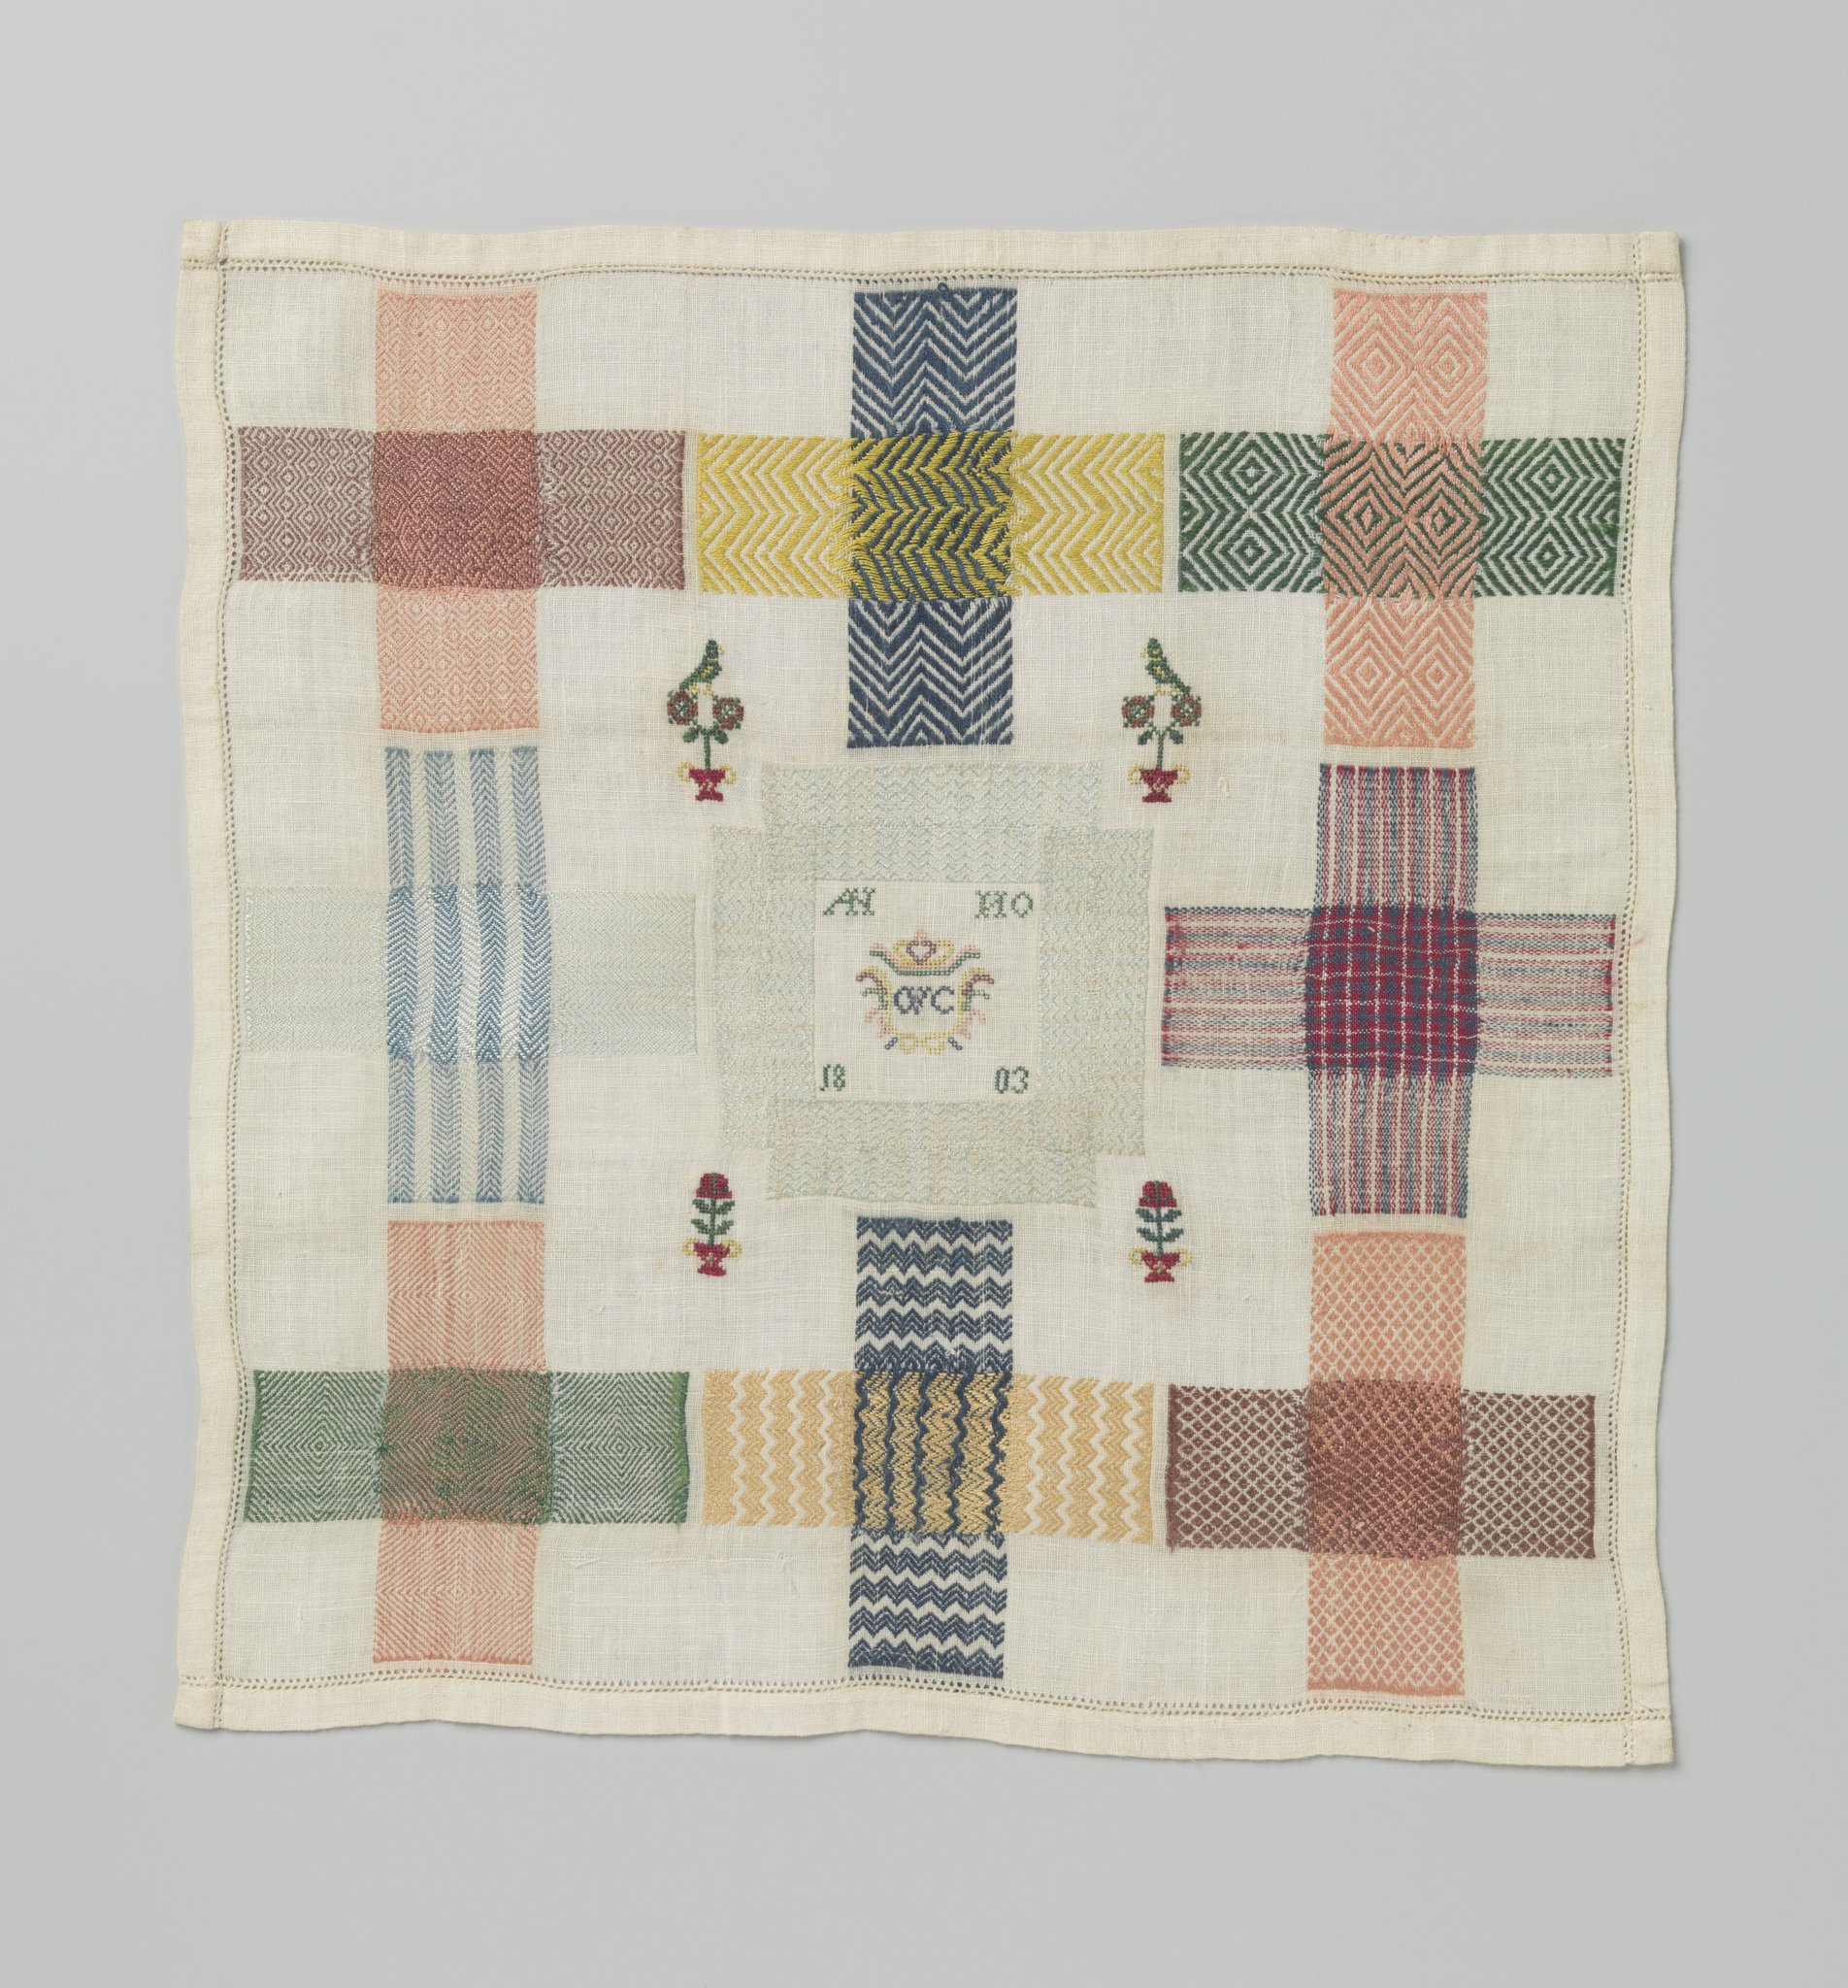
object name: stoplap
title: Stoplap van veelkleurige zijde op linnen.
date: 1803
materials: linen, silk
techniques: embroidered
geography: netherlands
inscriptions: date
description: Stoplap met veelkleurig borduurwerk. Het borduurwerk bestaat uit het jaartal ANNO 1803 en een vierkant waarbinnen de initialen CVC.